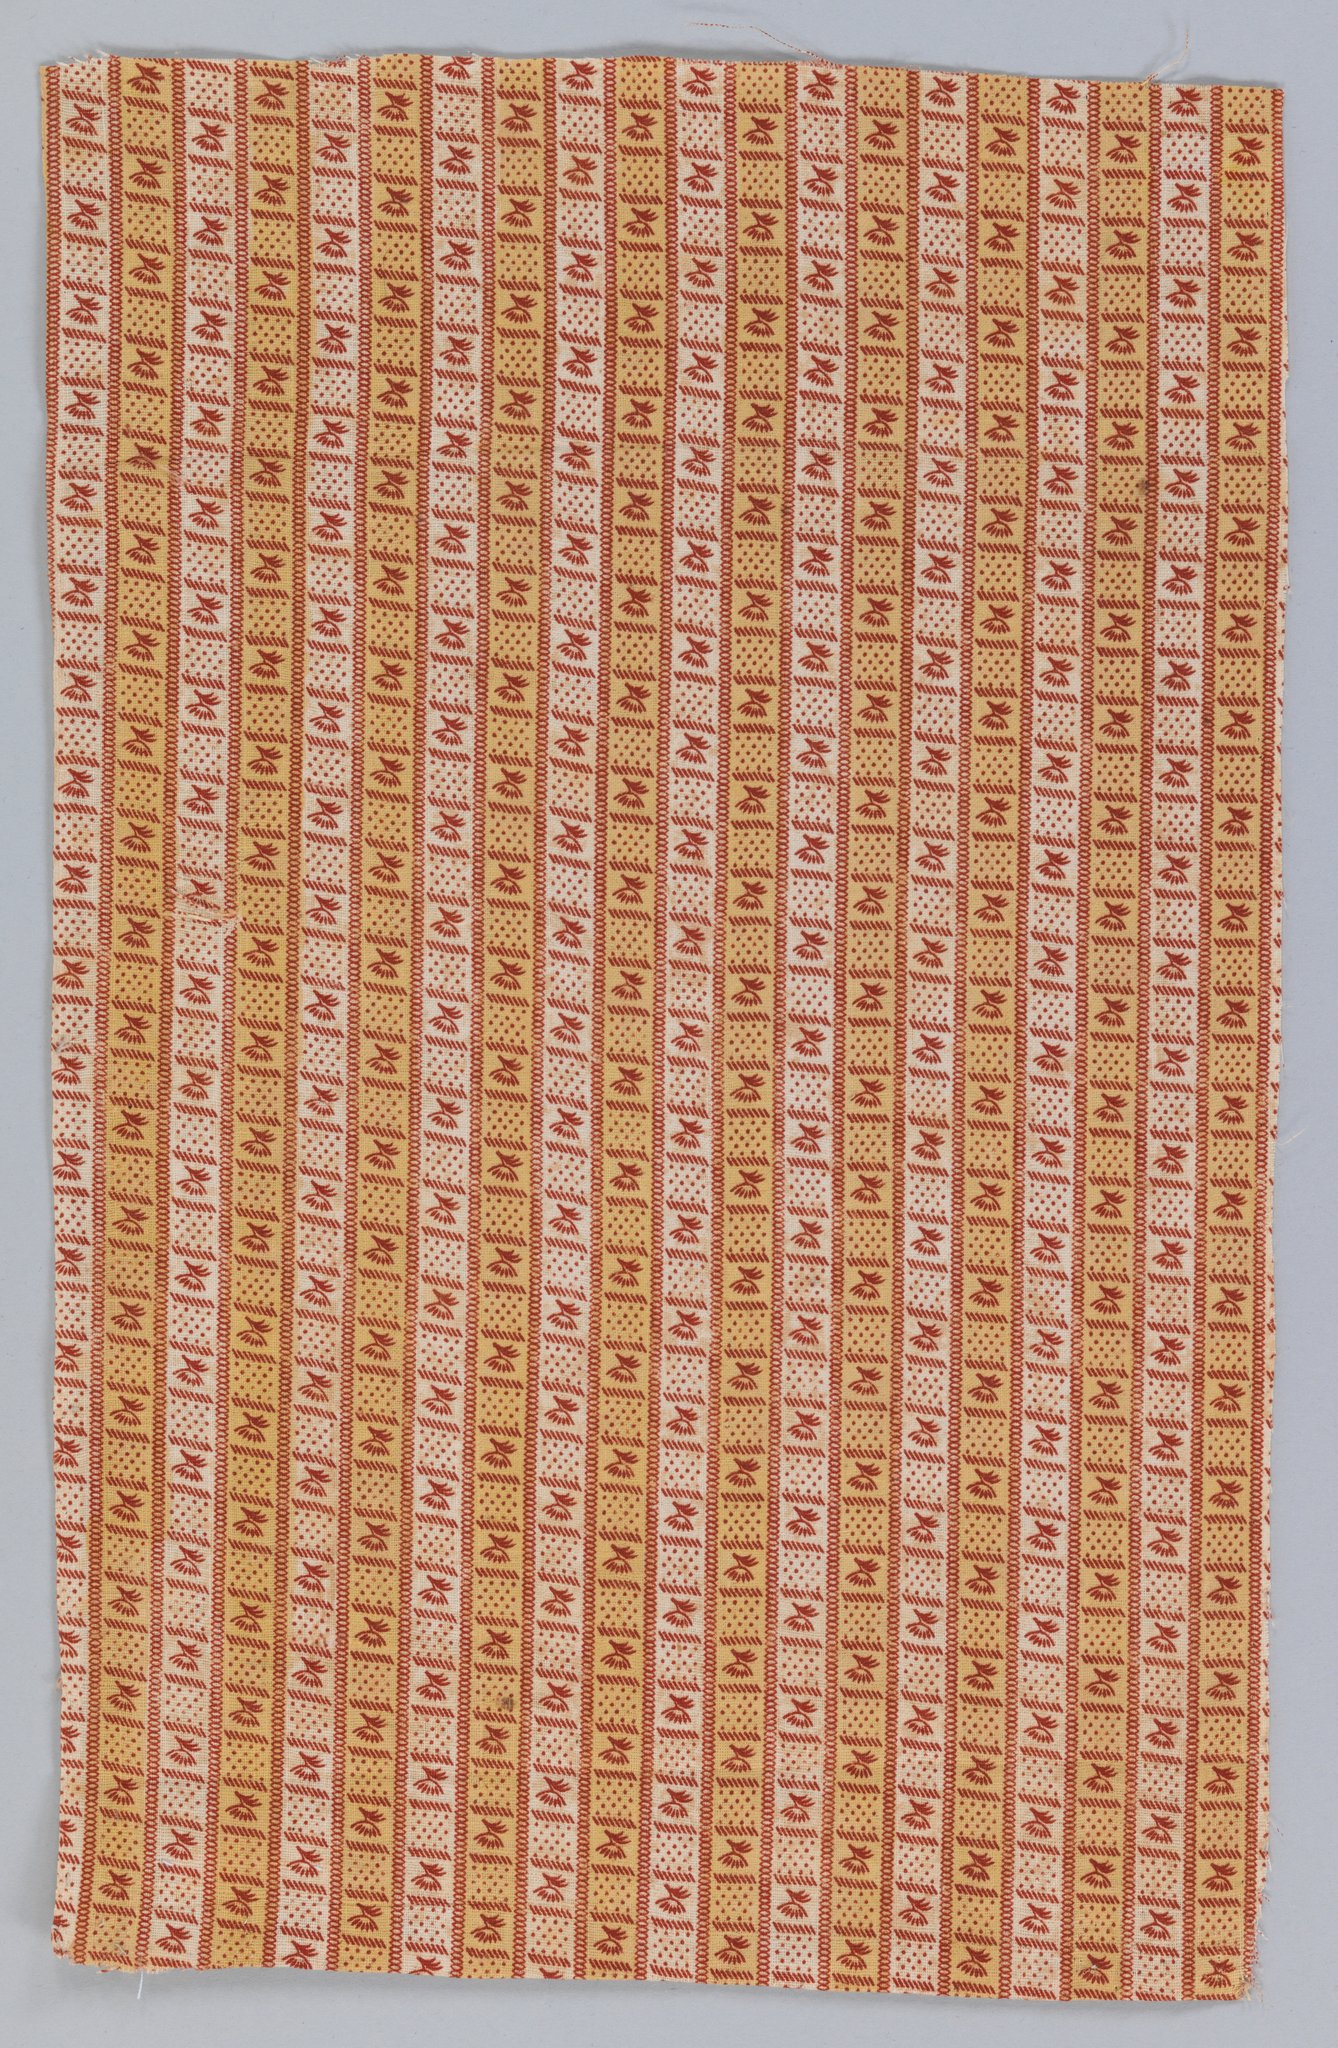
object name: piece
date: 1801-1900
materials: cotton